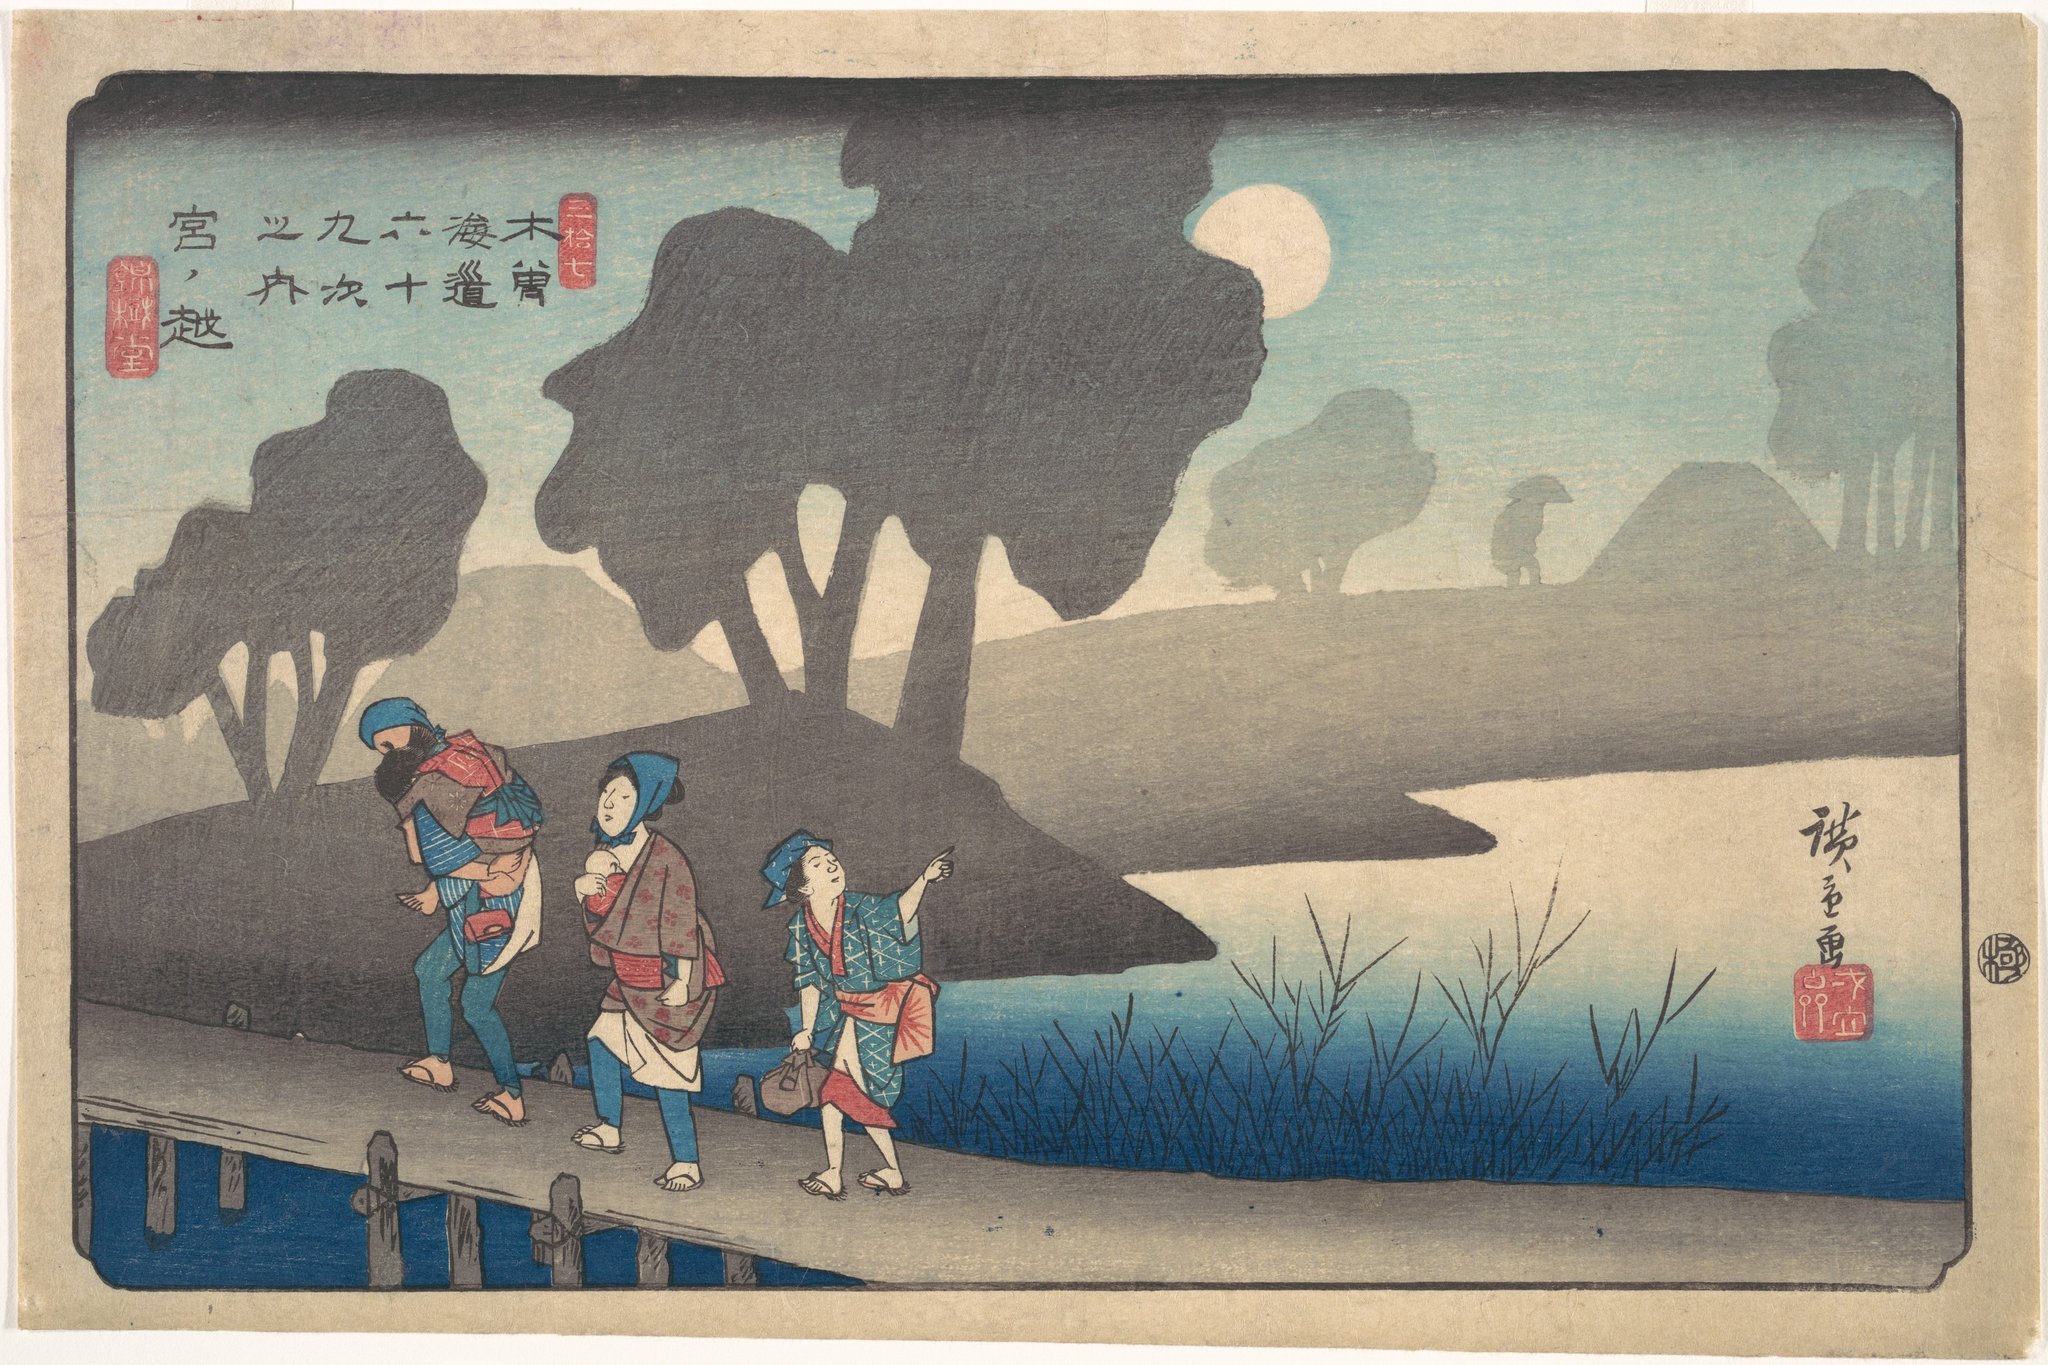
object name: print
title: Moonlit Night at Miyanokoshi, from The Sixty-nine Stations of the Kisokaidō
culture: japanese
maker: utagawa hiroshige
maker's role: artist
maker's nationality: japanese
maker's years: 1797-1858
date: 1838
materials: ink, paper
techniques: woodblock print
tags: human figures,bridges,trees,night